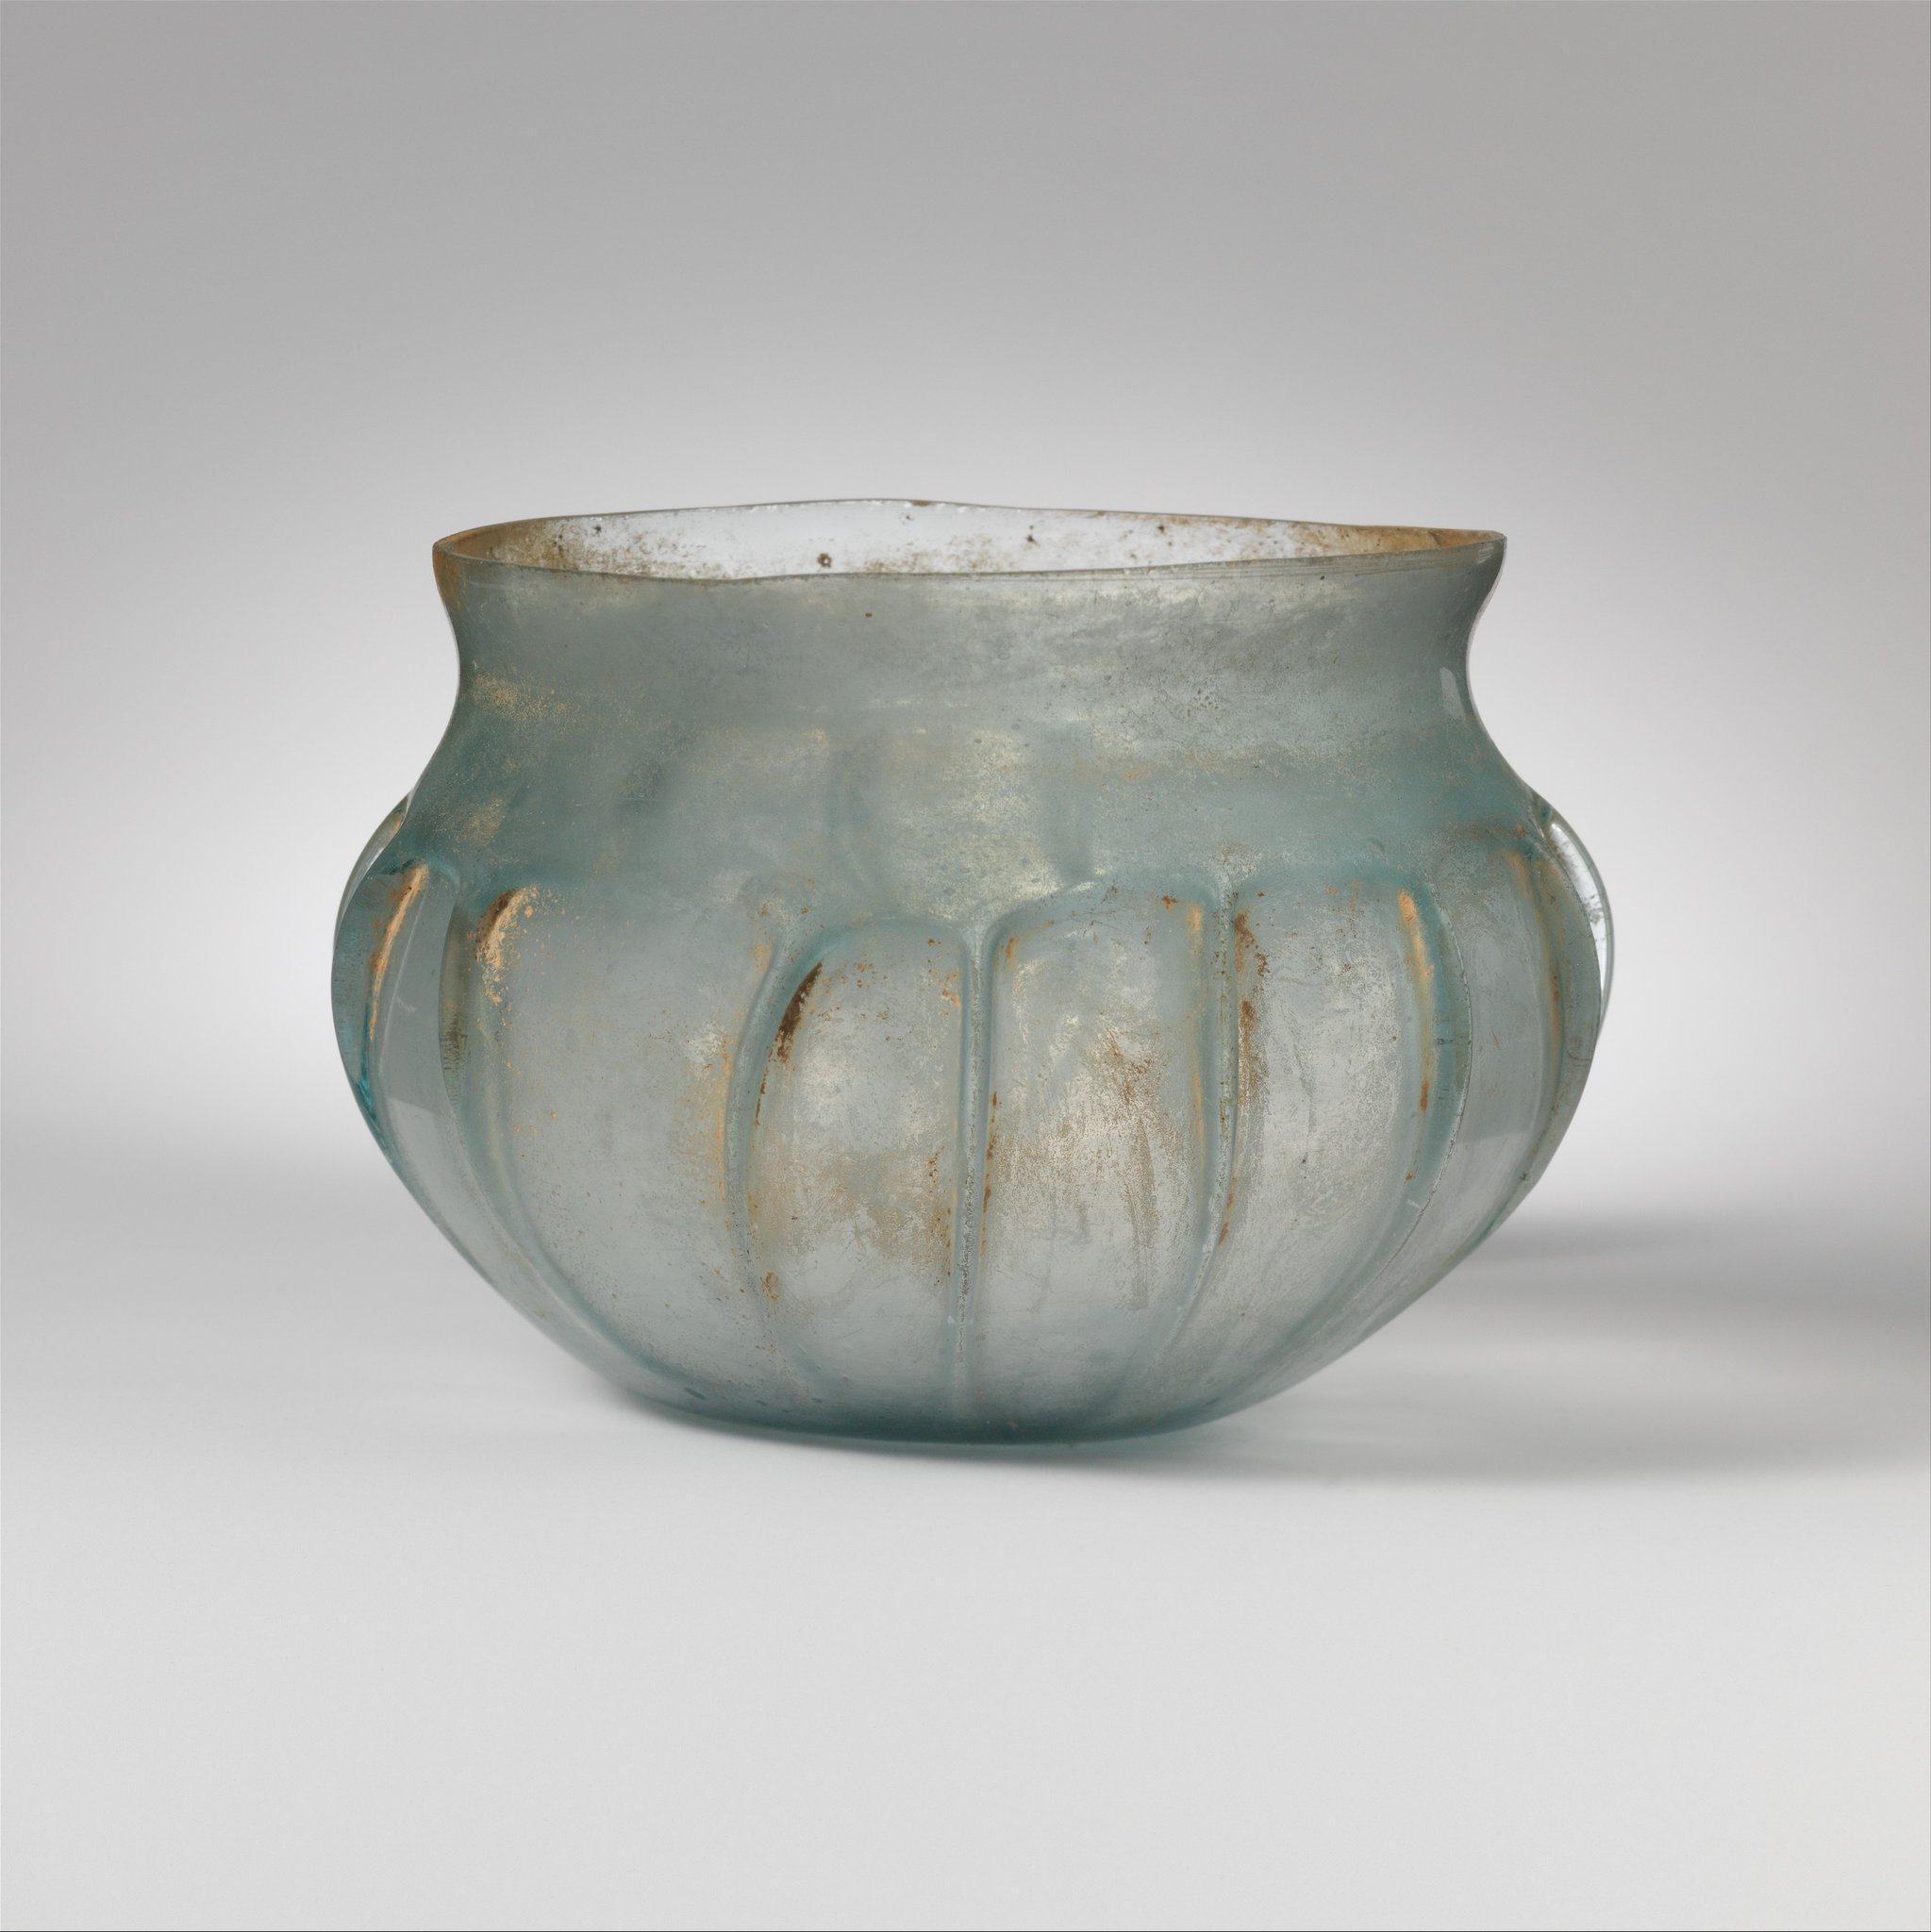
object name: bowl, rippenschale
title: Glass ribbed bowl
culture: roman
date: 34-66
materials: glass